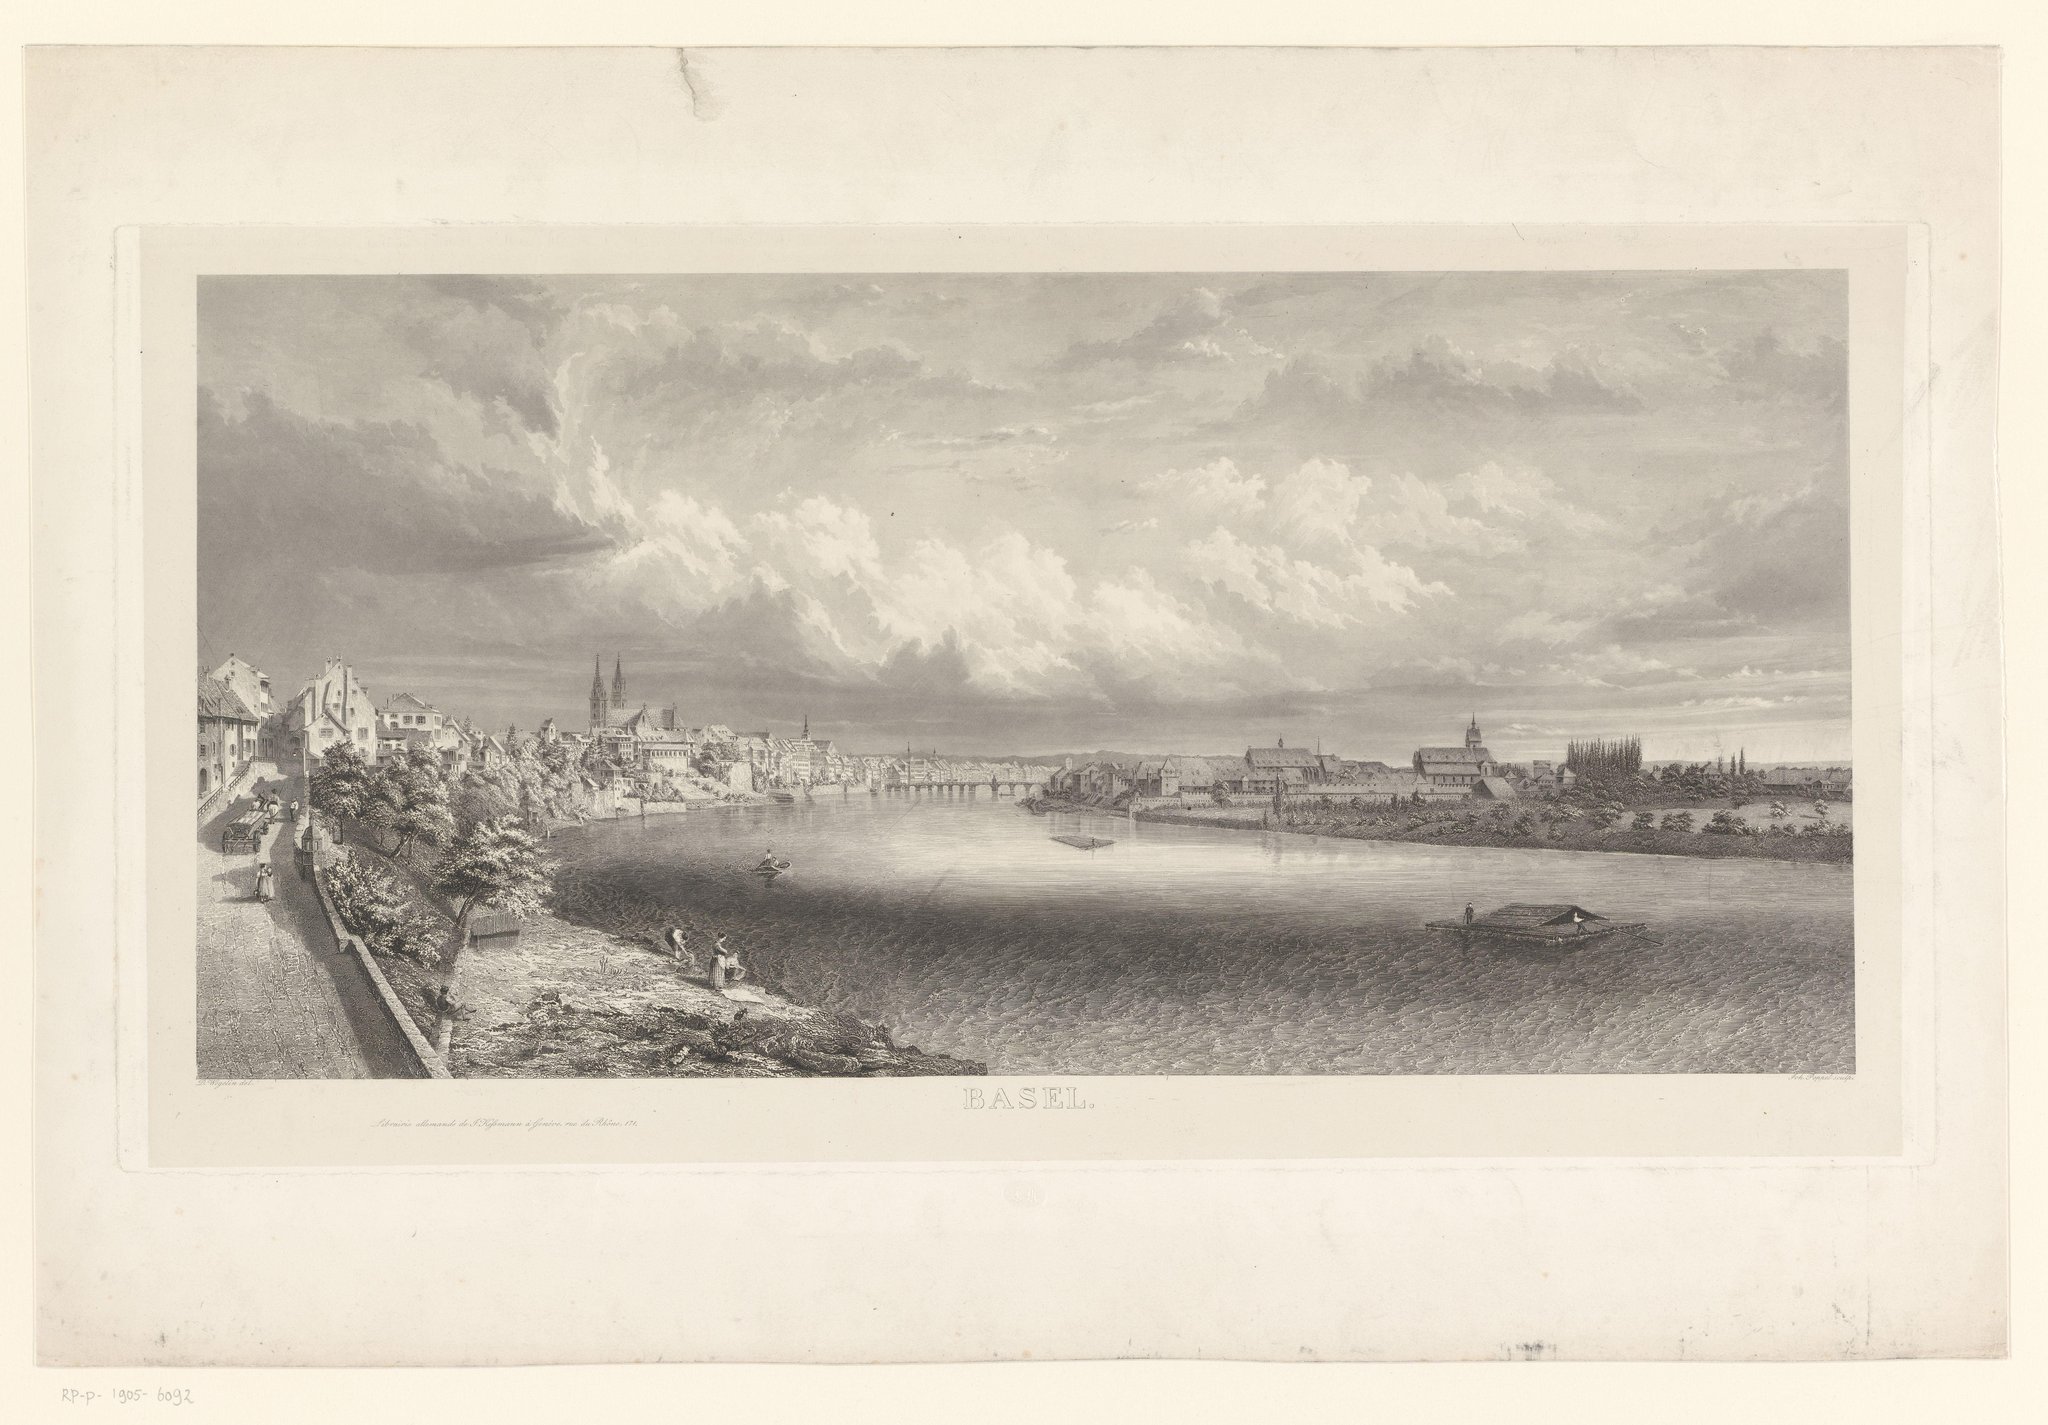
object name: print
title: Gezicht op de Bazel en de Rijn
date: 1817-1882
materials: paper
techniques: engraving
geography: geneva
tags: river, city-view in general; 'veduta' (+ city(-scape) with figures, staffage)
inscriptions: collector's mark: ‘JR’, collector's mark: Lugt 2228